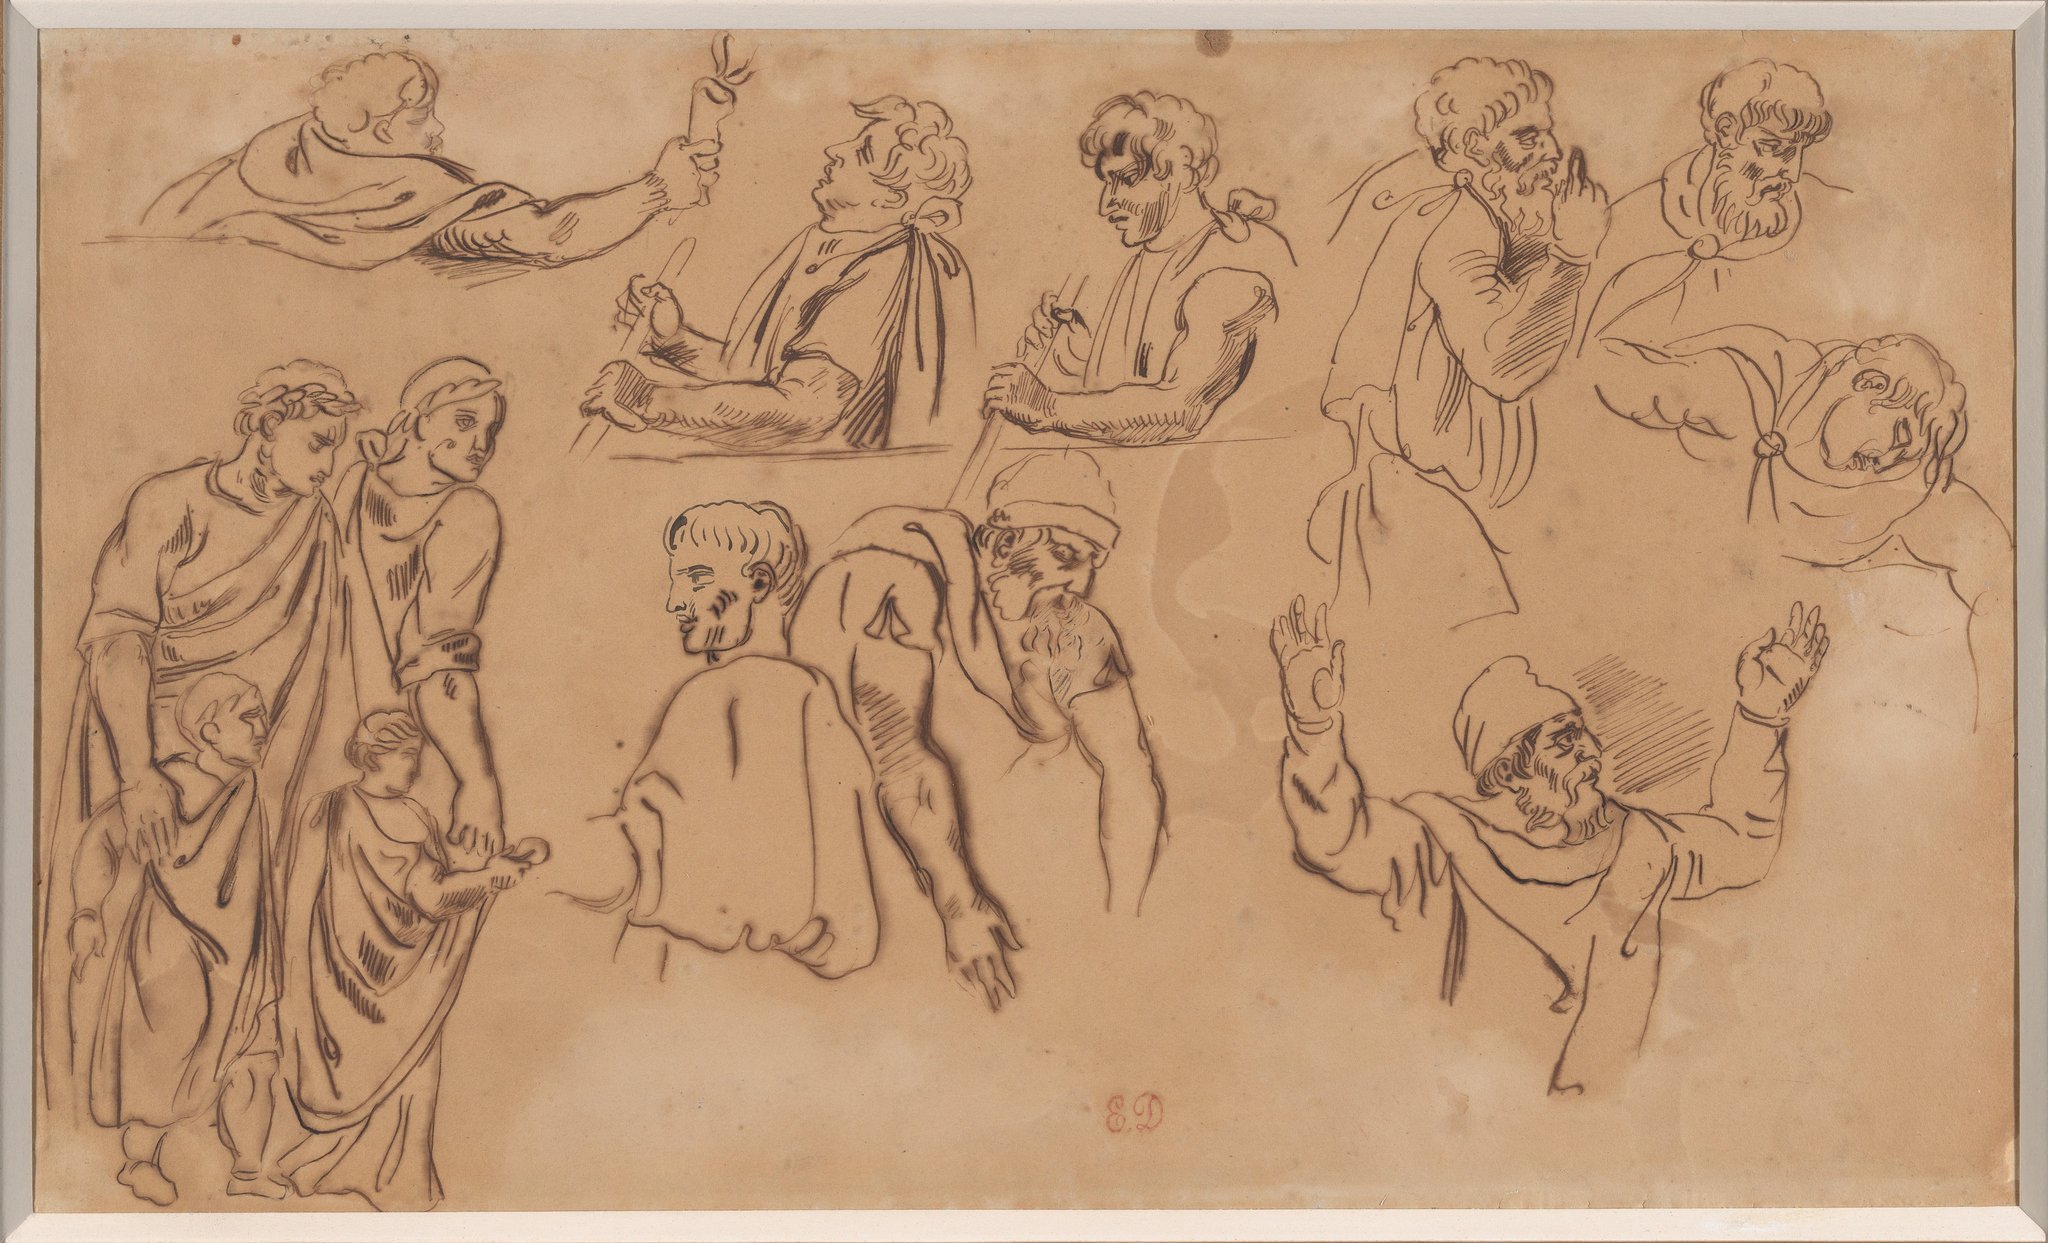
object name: drawing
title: Study of Thirteen Figures from the Antique (recto); Study of a Family, traced from the recto (verso)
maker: eugène delacroix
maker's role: artist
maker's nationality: french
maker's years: 1798-1863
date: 1822-1826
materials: ink, iron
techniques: pen